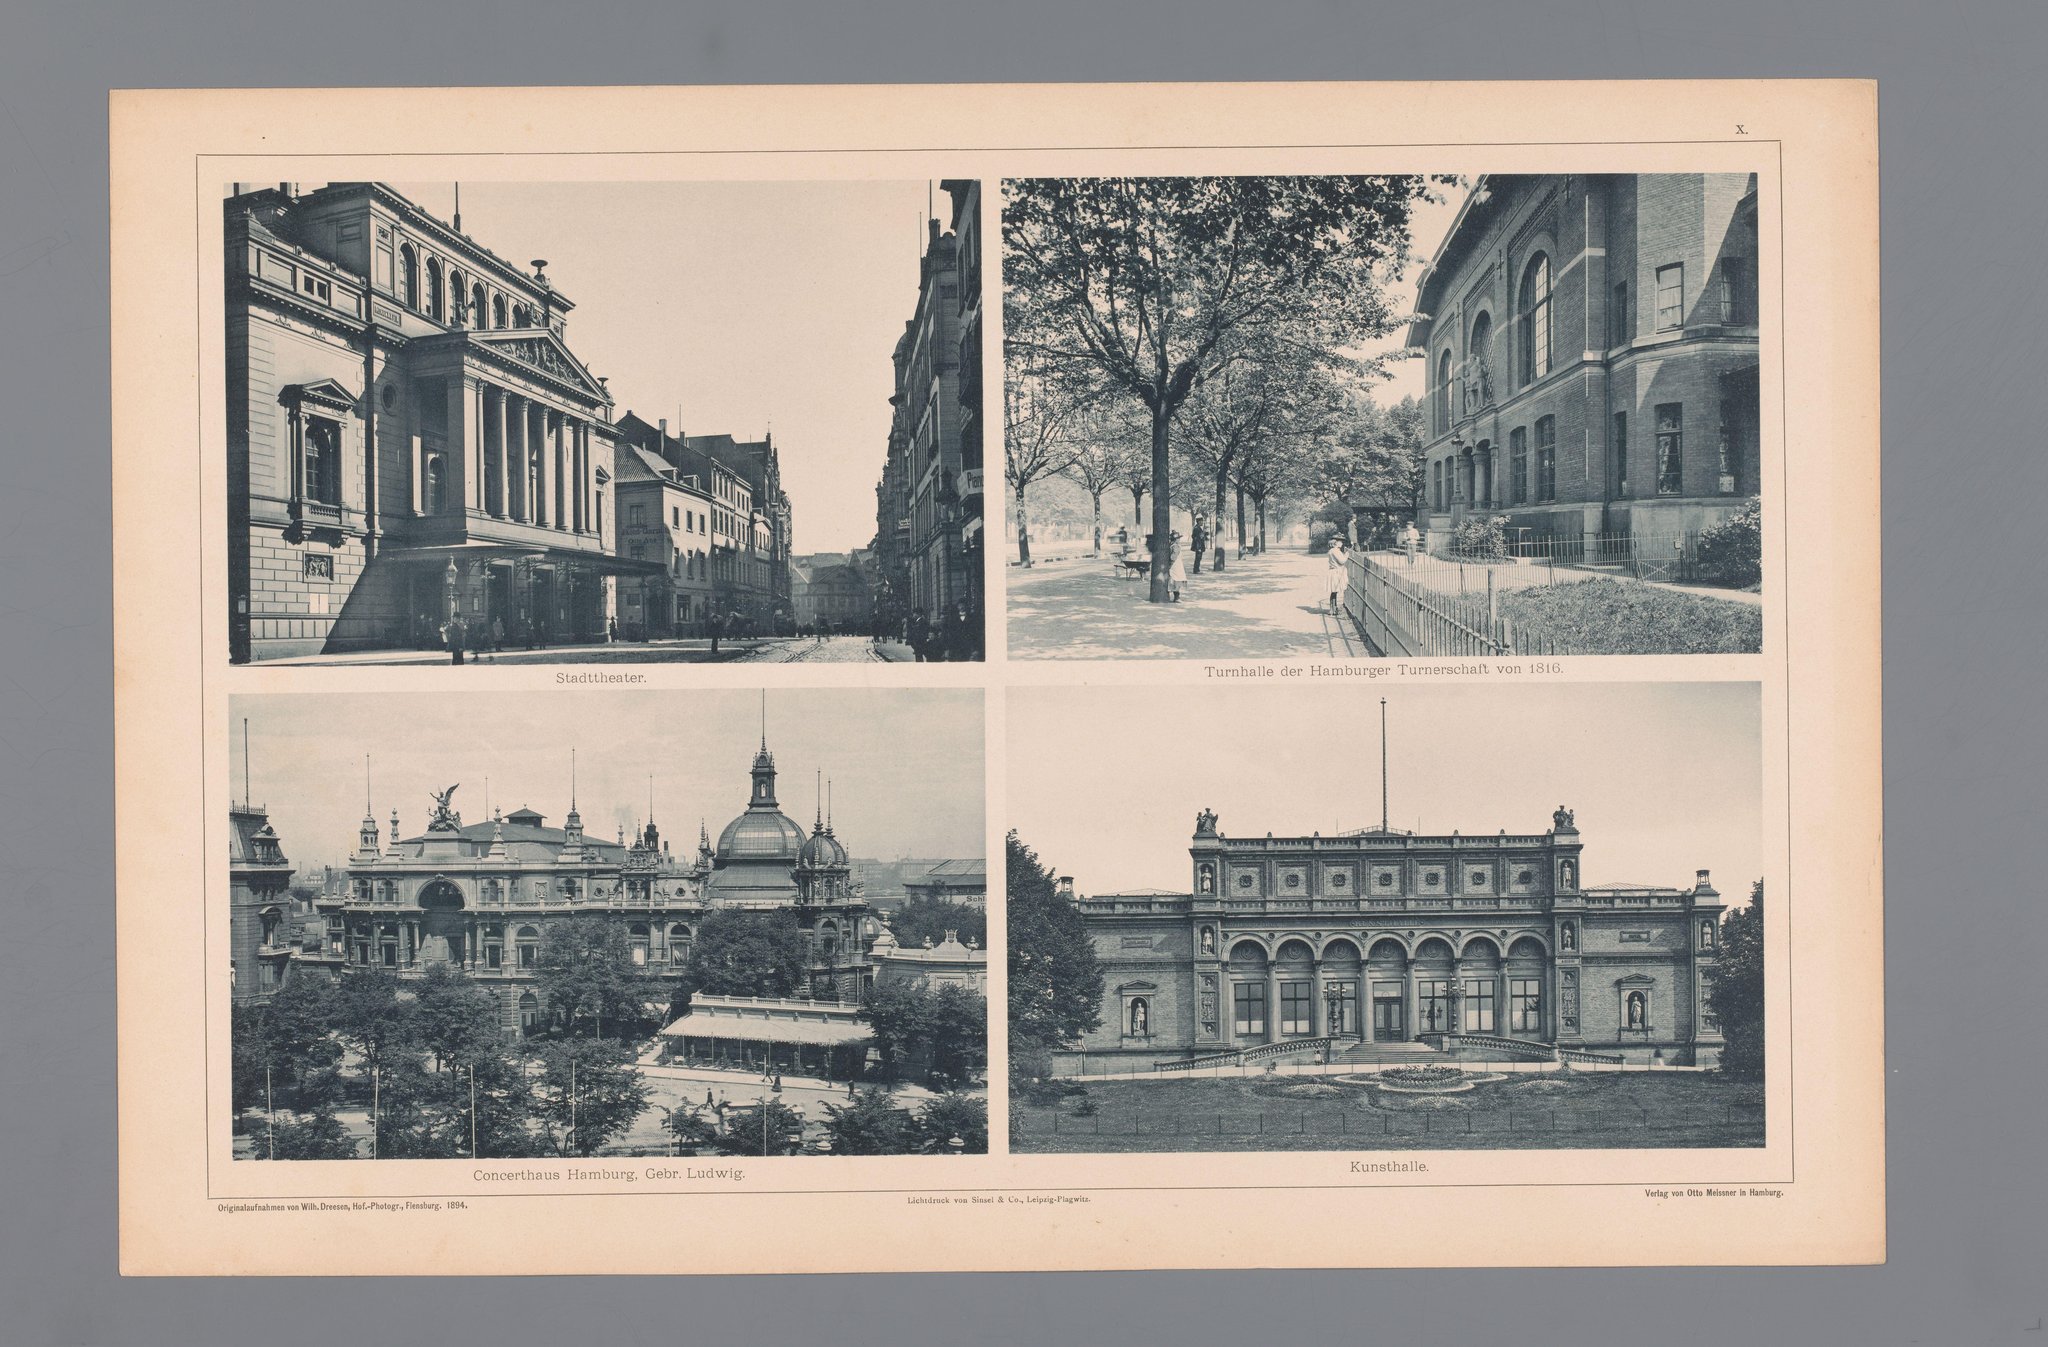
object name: photomechanical print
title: Kunsthallet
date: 1894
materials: paper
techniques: photograph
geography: hamburg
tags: theatre (building), permanent exhibition, museum, concert hall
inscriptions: inscription: ‘Originalaufnahmen von Wilh. Dreesen, Hof.-Photogr., Flensburg. 1894.’, number: ‘X.’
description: Deze prenten maken deel uit van een omslag met 126 prenten op 37 bladen en een tekstblad.